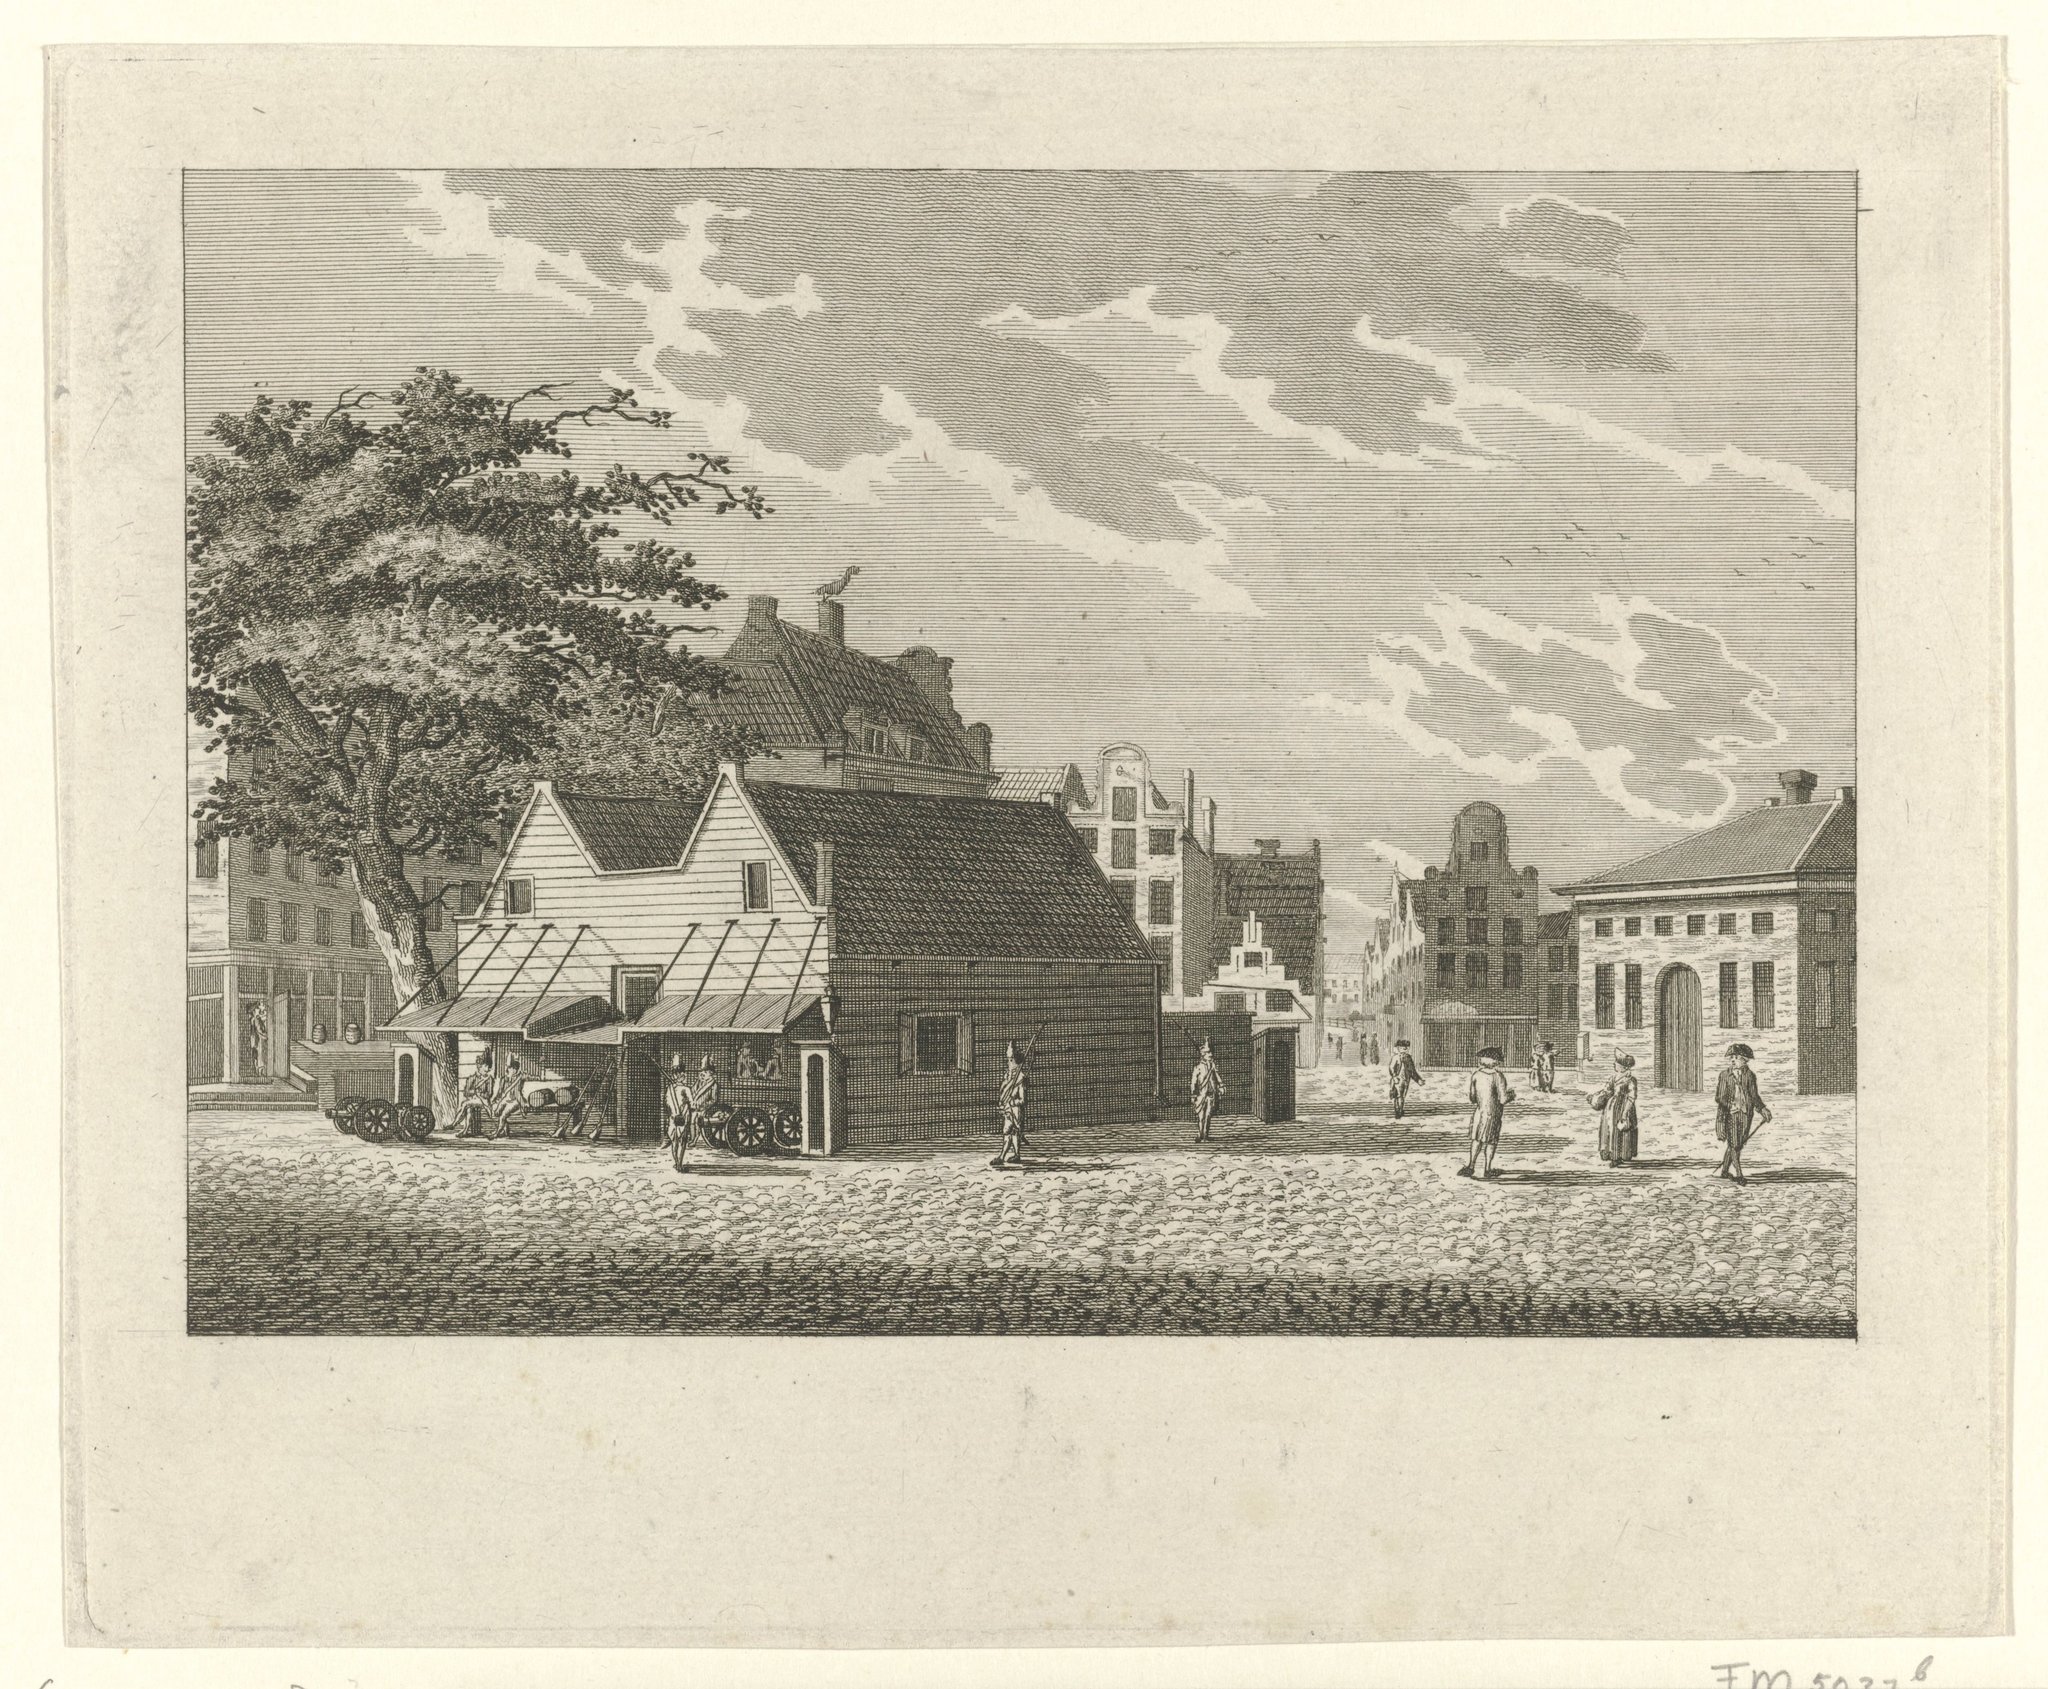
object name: print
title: Hoofdwacht van de landsmilitie op de Botermarkt te Amsterdam, 1788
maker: jacobus wijsman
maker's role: print maker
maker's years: 1768-1827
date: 1788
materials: paper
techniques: engraving, etching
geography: northern netherlands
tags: guard duty, keeping sentry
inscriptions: collector's mark: Lugt 2228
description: Gezicht op de militaire hoofdwacht van de landsmilitie op de Botermarkt (op het huidige Rembrandtsplein) te Amsterdam, 1788.